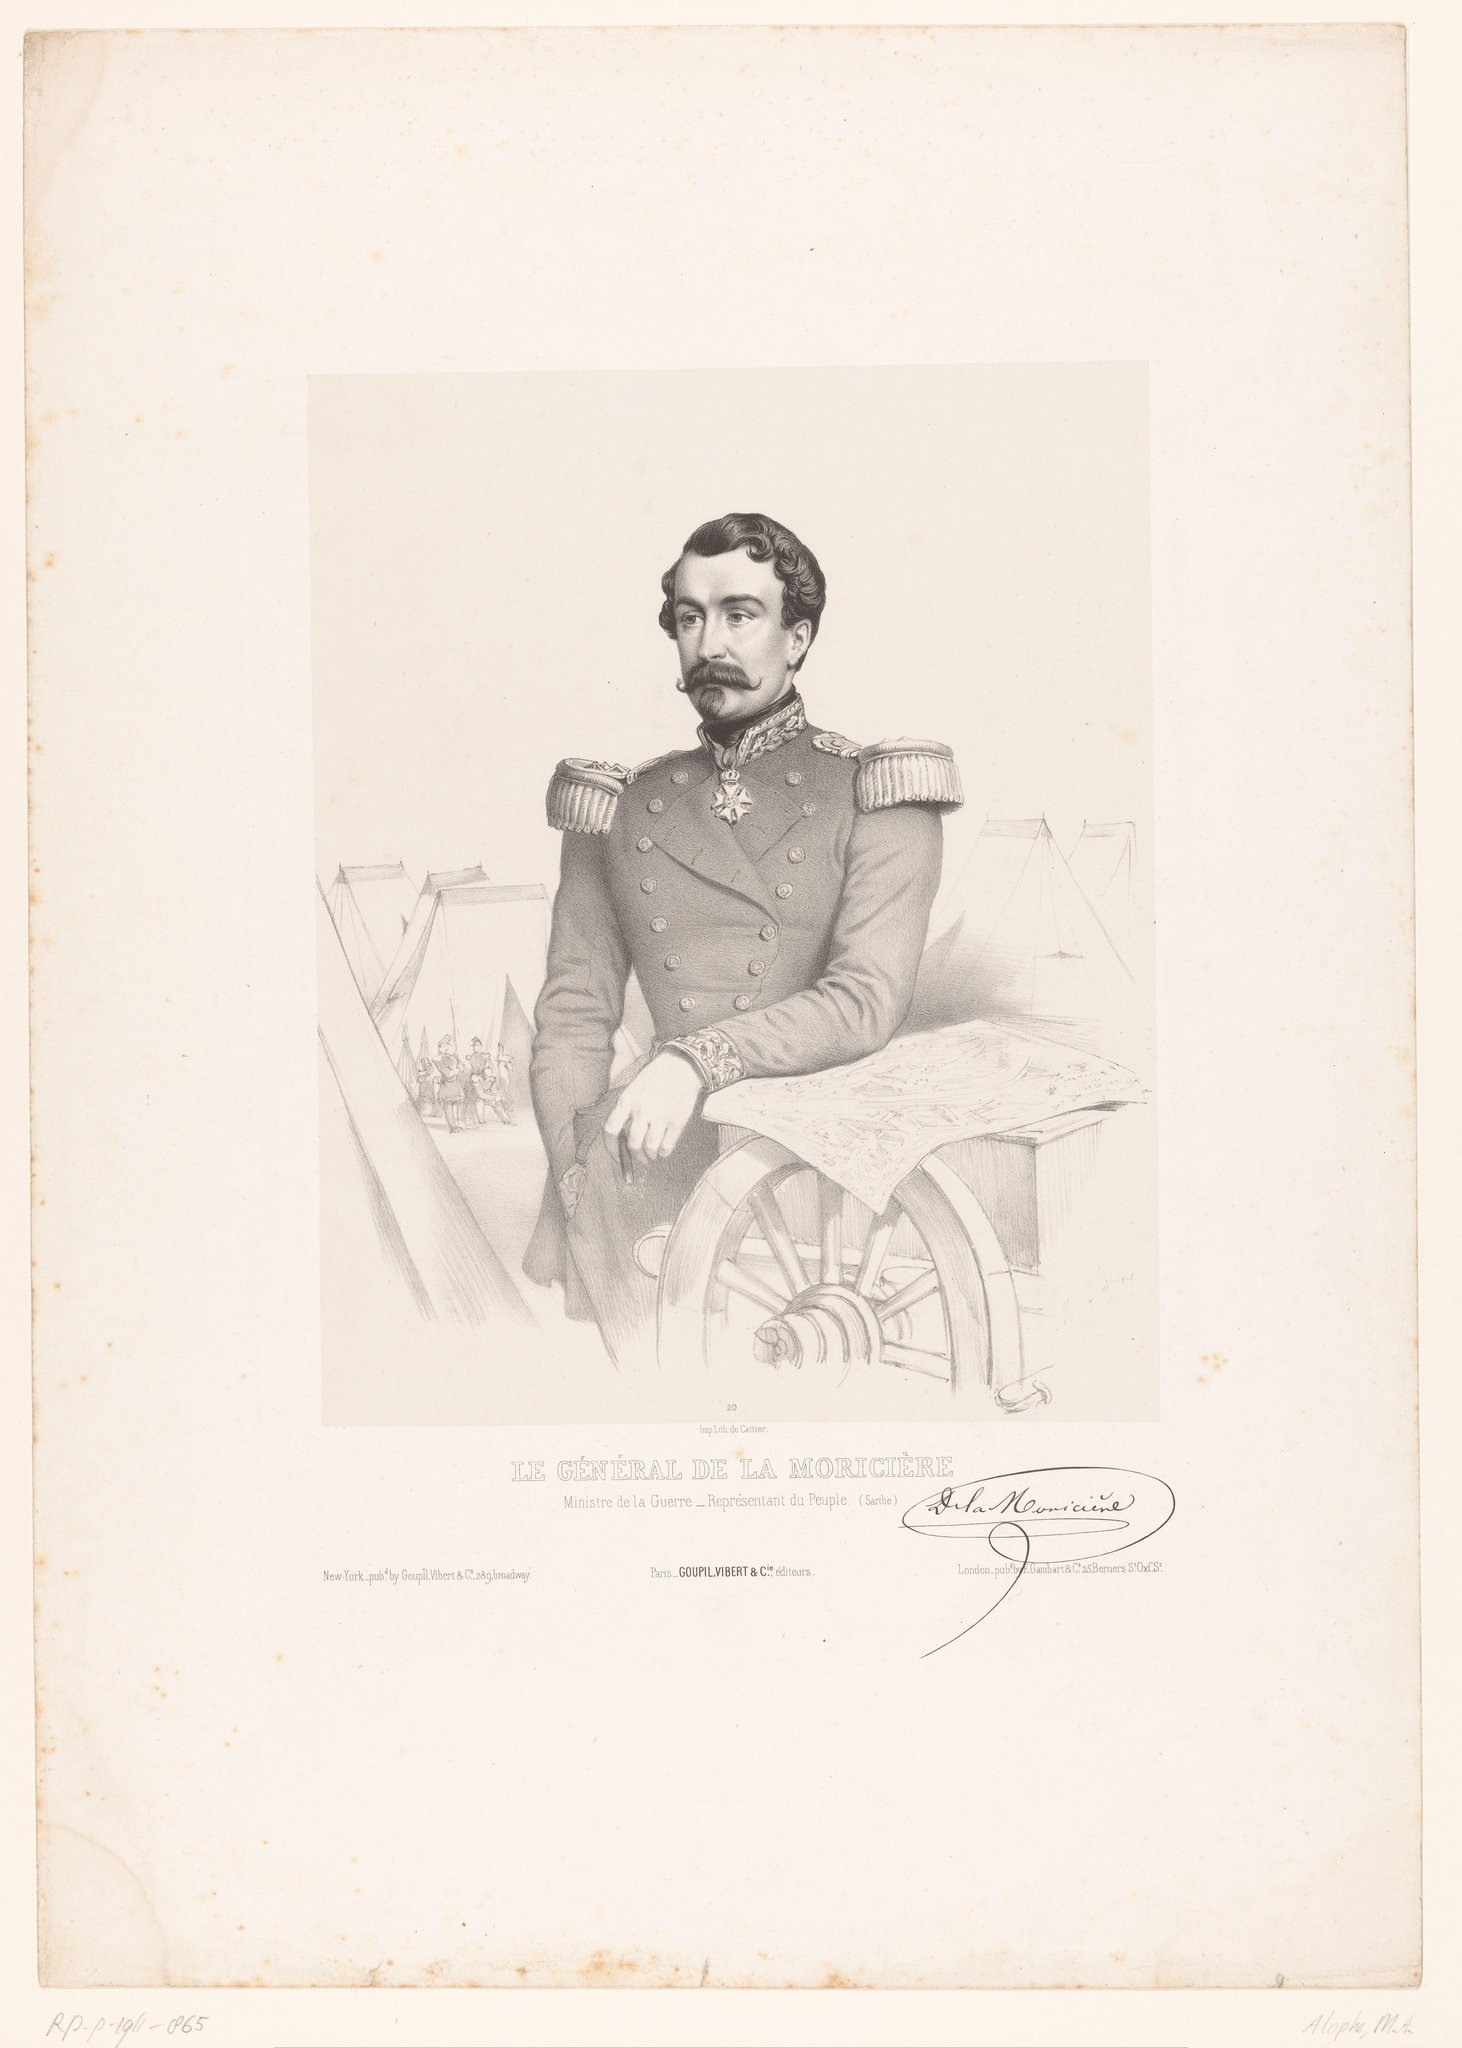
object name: print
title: Le général de la Moricière. Ministre de la guerre, représentant du peuple (Sarthe)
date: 1848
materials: paper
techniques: lithography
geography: paris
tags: historical persons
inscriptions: check stamp: Lugt 5004, collector's mark: Lugt 2228